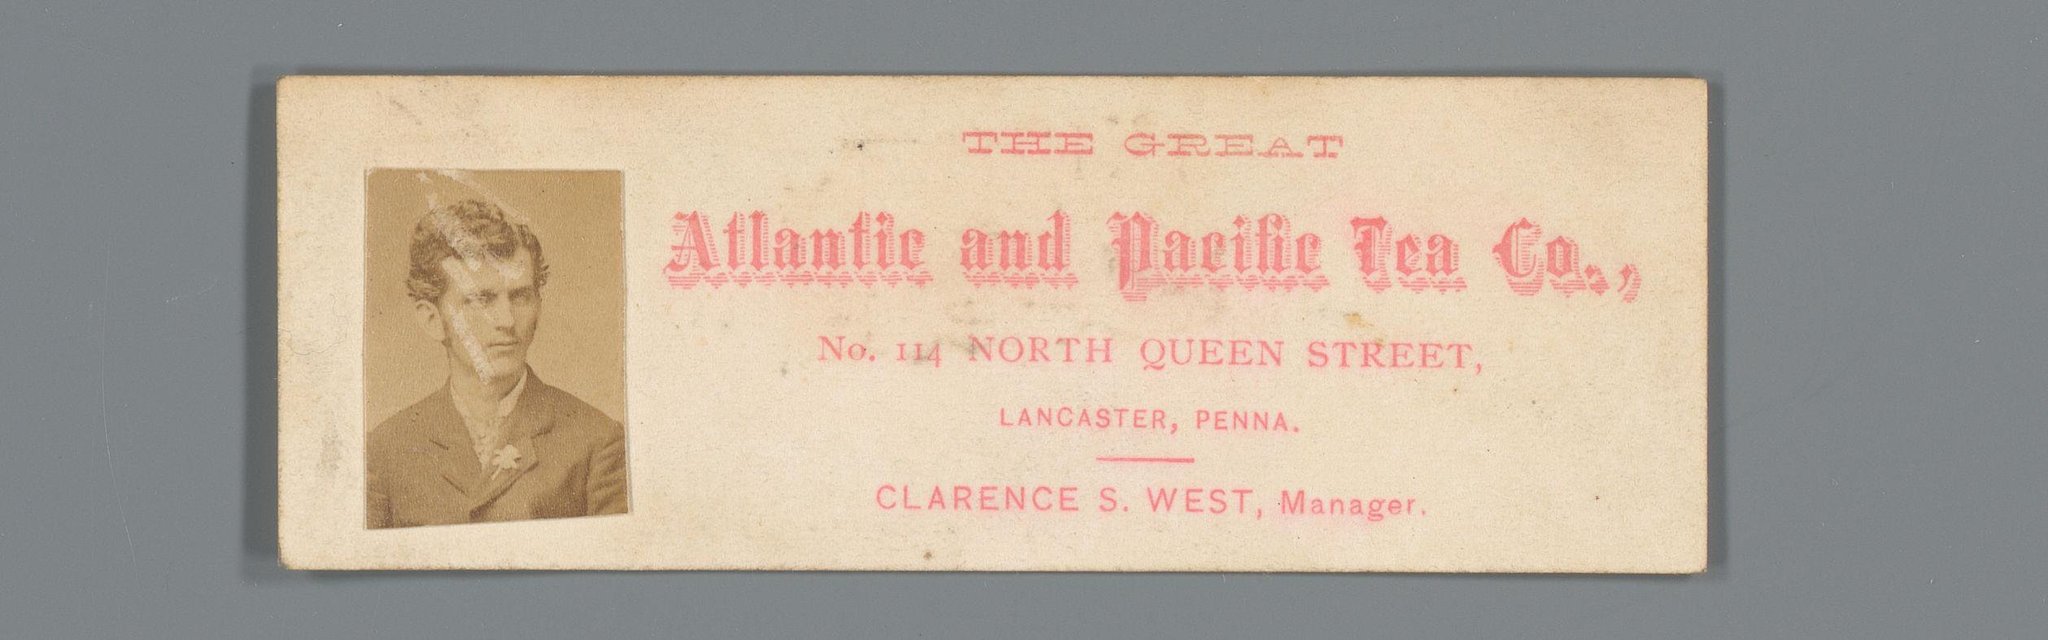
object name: photograph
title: Portret van een man, mogelijk de manager van The Great Atlantic en Pacific Tea Company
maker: Anonymous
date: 1850-1915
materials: cardboard, photographic support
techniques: albumen print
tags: advertising, tea (leaves), historical persons not known by name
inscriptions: inscription: ‘TRY THE/ 8 O'Clock Breakfast/ Coffee./ 25 Cents Per Pound.’, inscription: ‘THE GREAT/ Atlantic and Pacific Tea Co.,/ No. 114 NORTH QUEEN STREET,/ LANCASTER, PENNA./ CLARENCE S. WEST, Manager.’